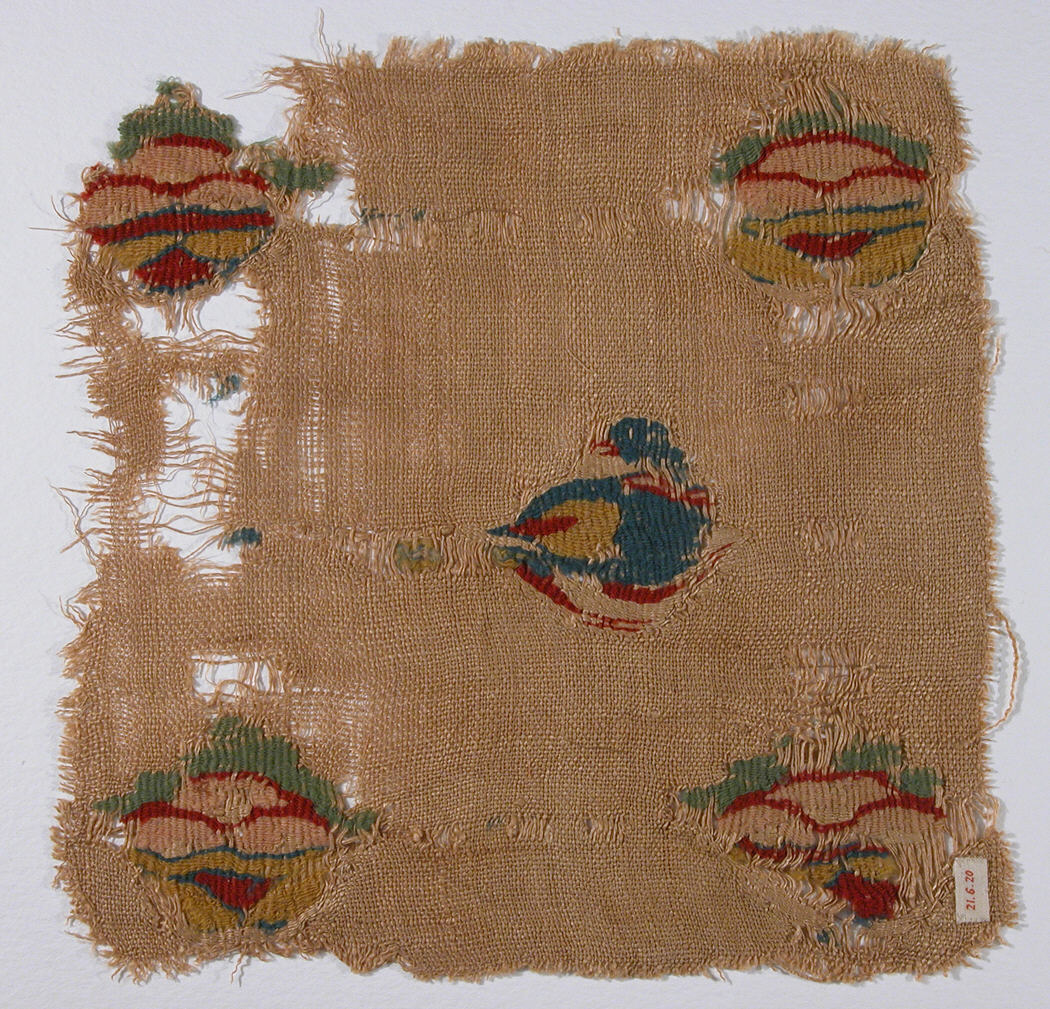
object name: fragment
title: Textile Fragment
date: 401-500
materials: linen, wool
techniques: tapestry, weave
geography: egypt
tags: birds